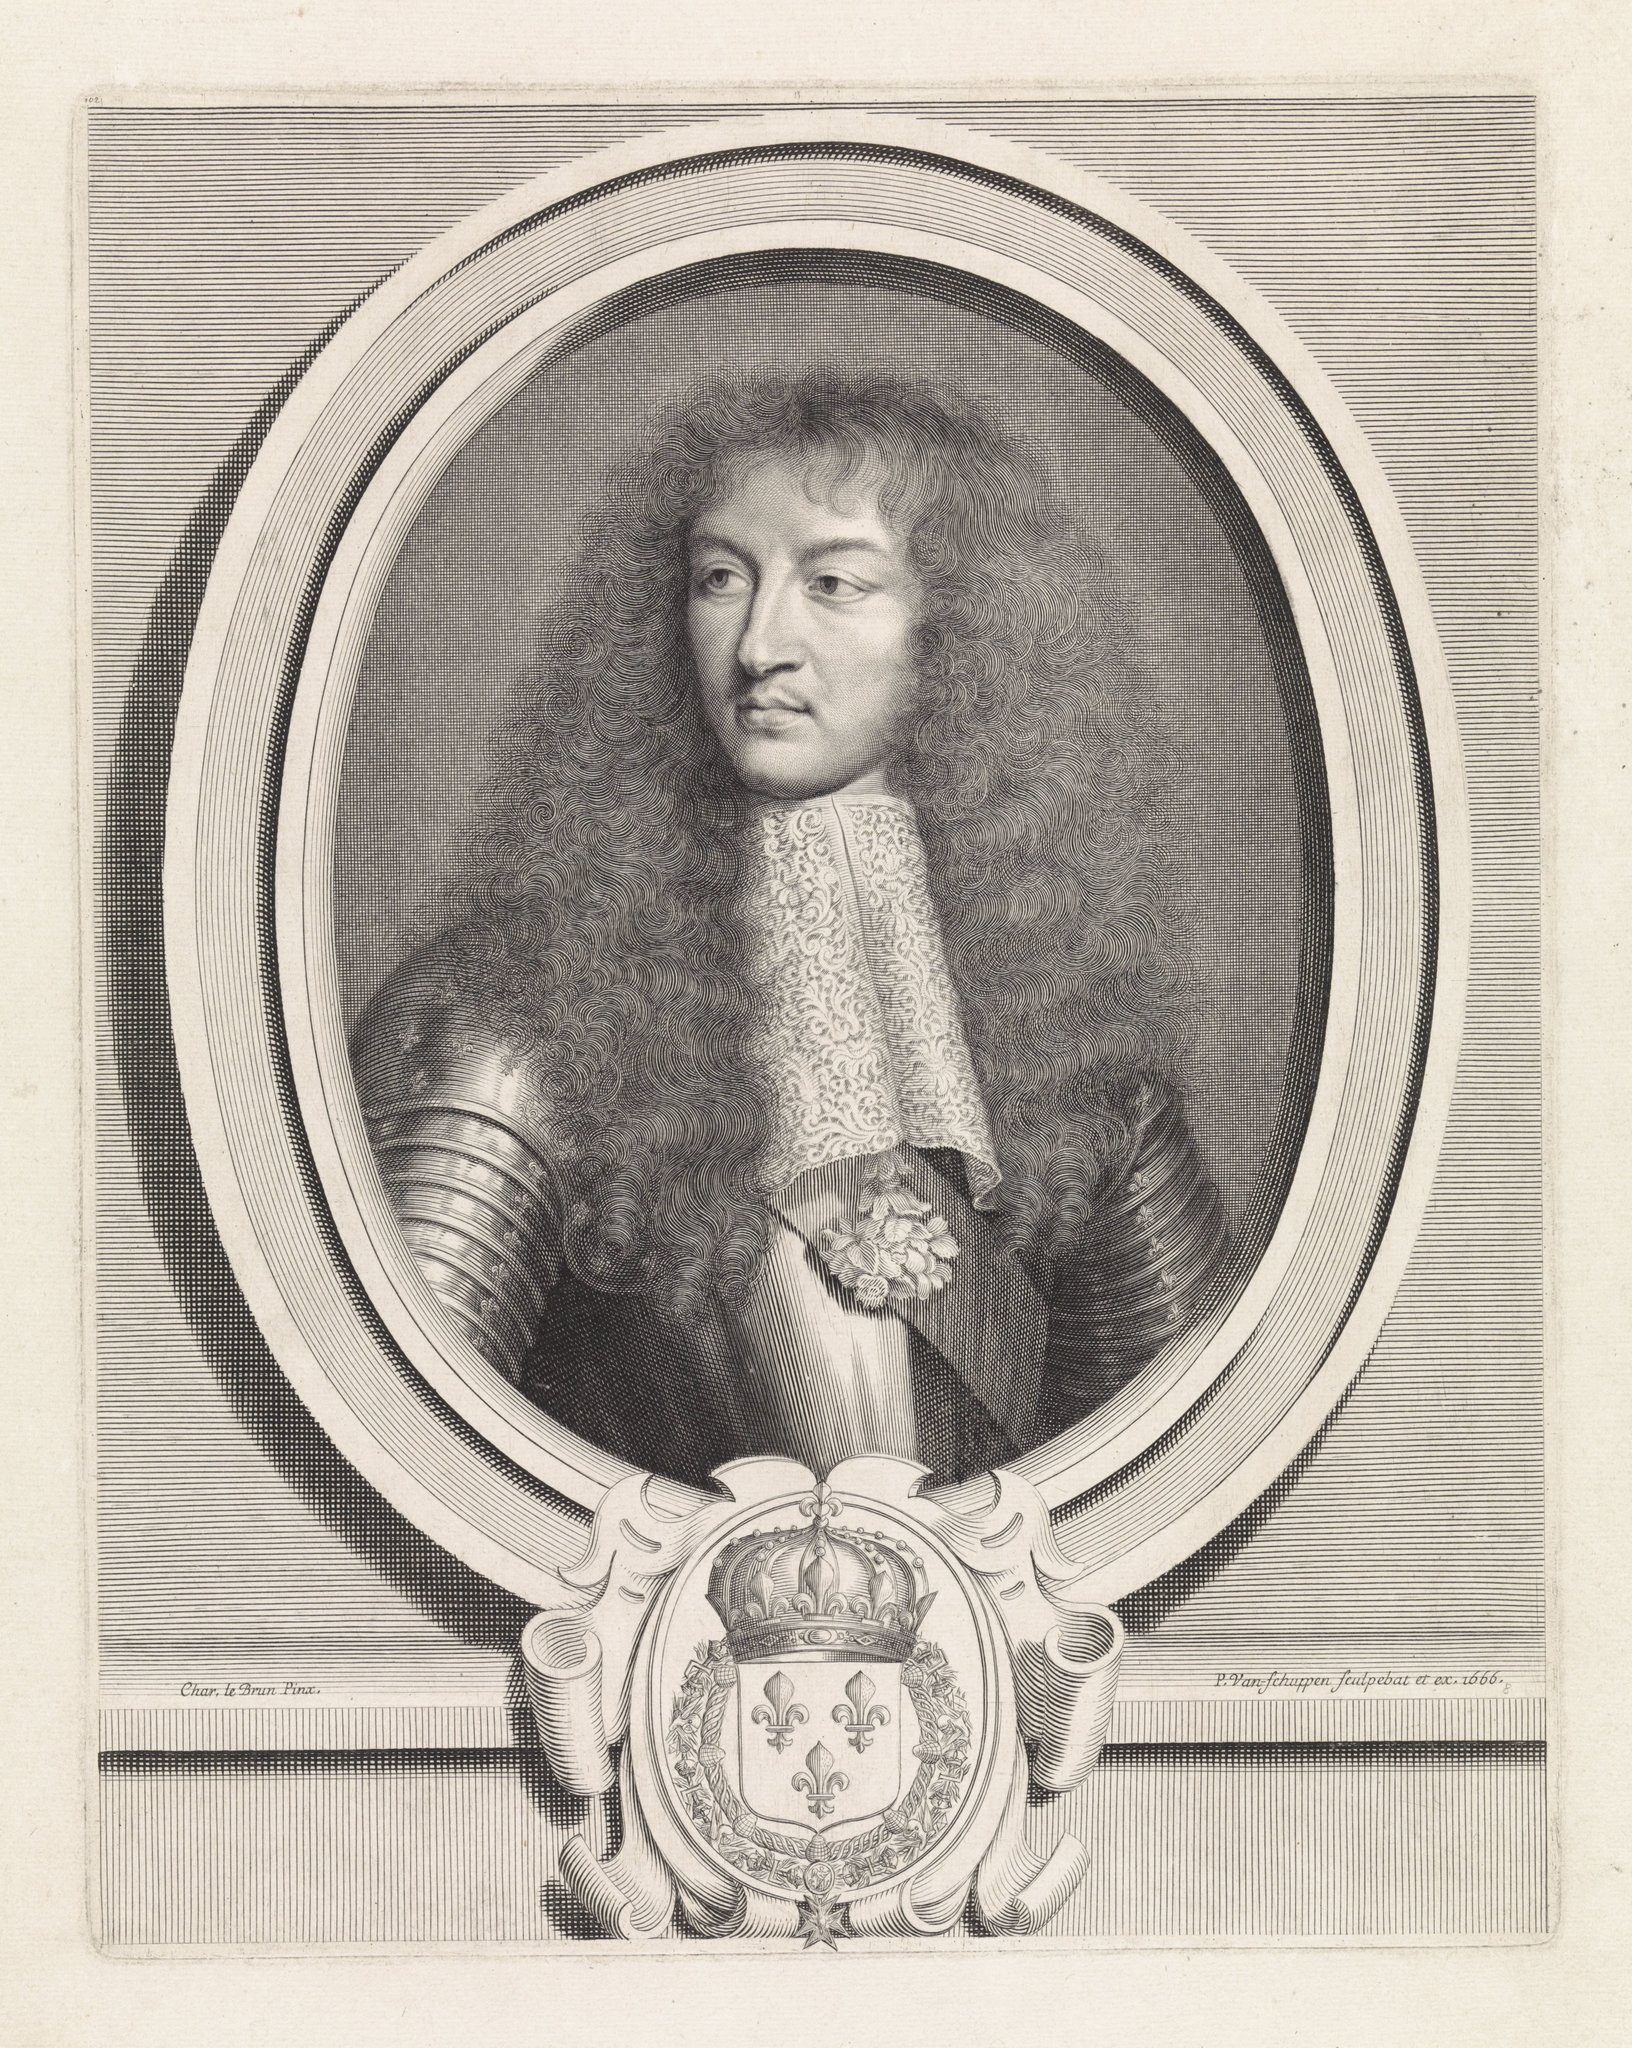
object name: print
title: Portret van Lodewijk XIV, koning van Frankrijk, met kanten kraag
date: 1608-1666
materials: paper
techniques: engraving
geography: paris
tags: lodewijk xiv (koning van frankrijk)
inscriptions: collector's mark: Lugt 2228